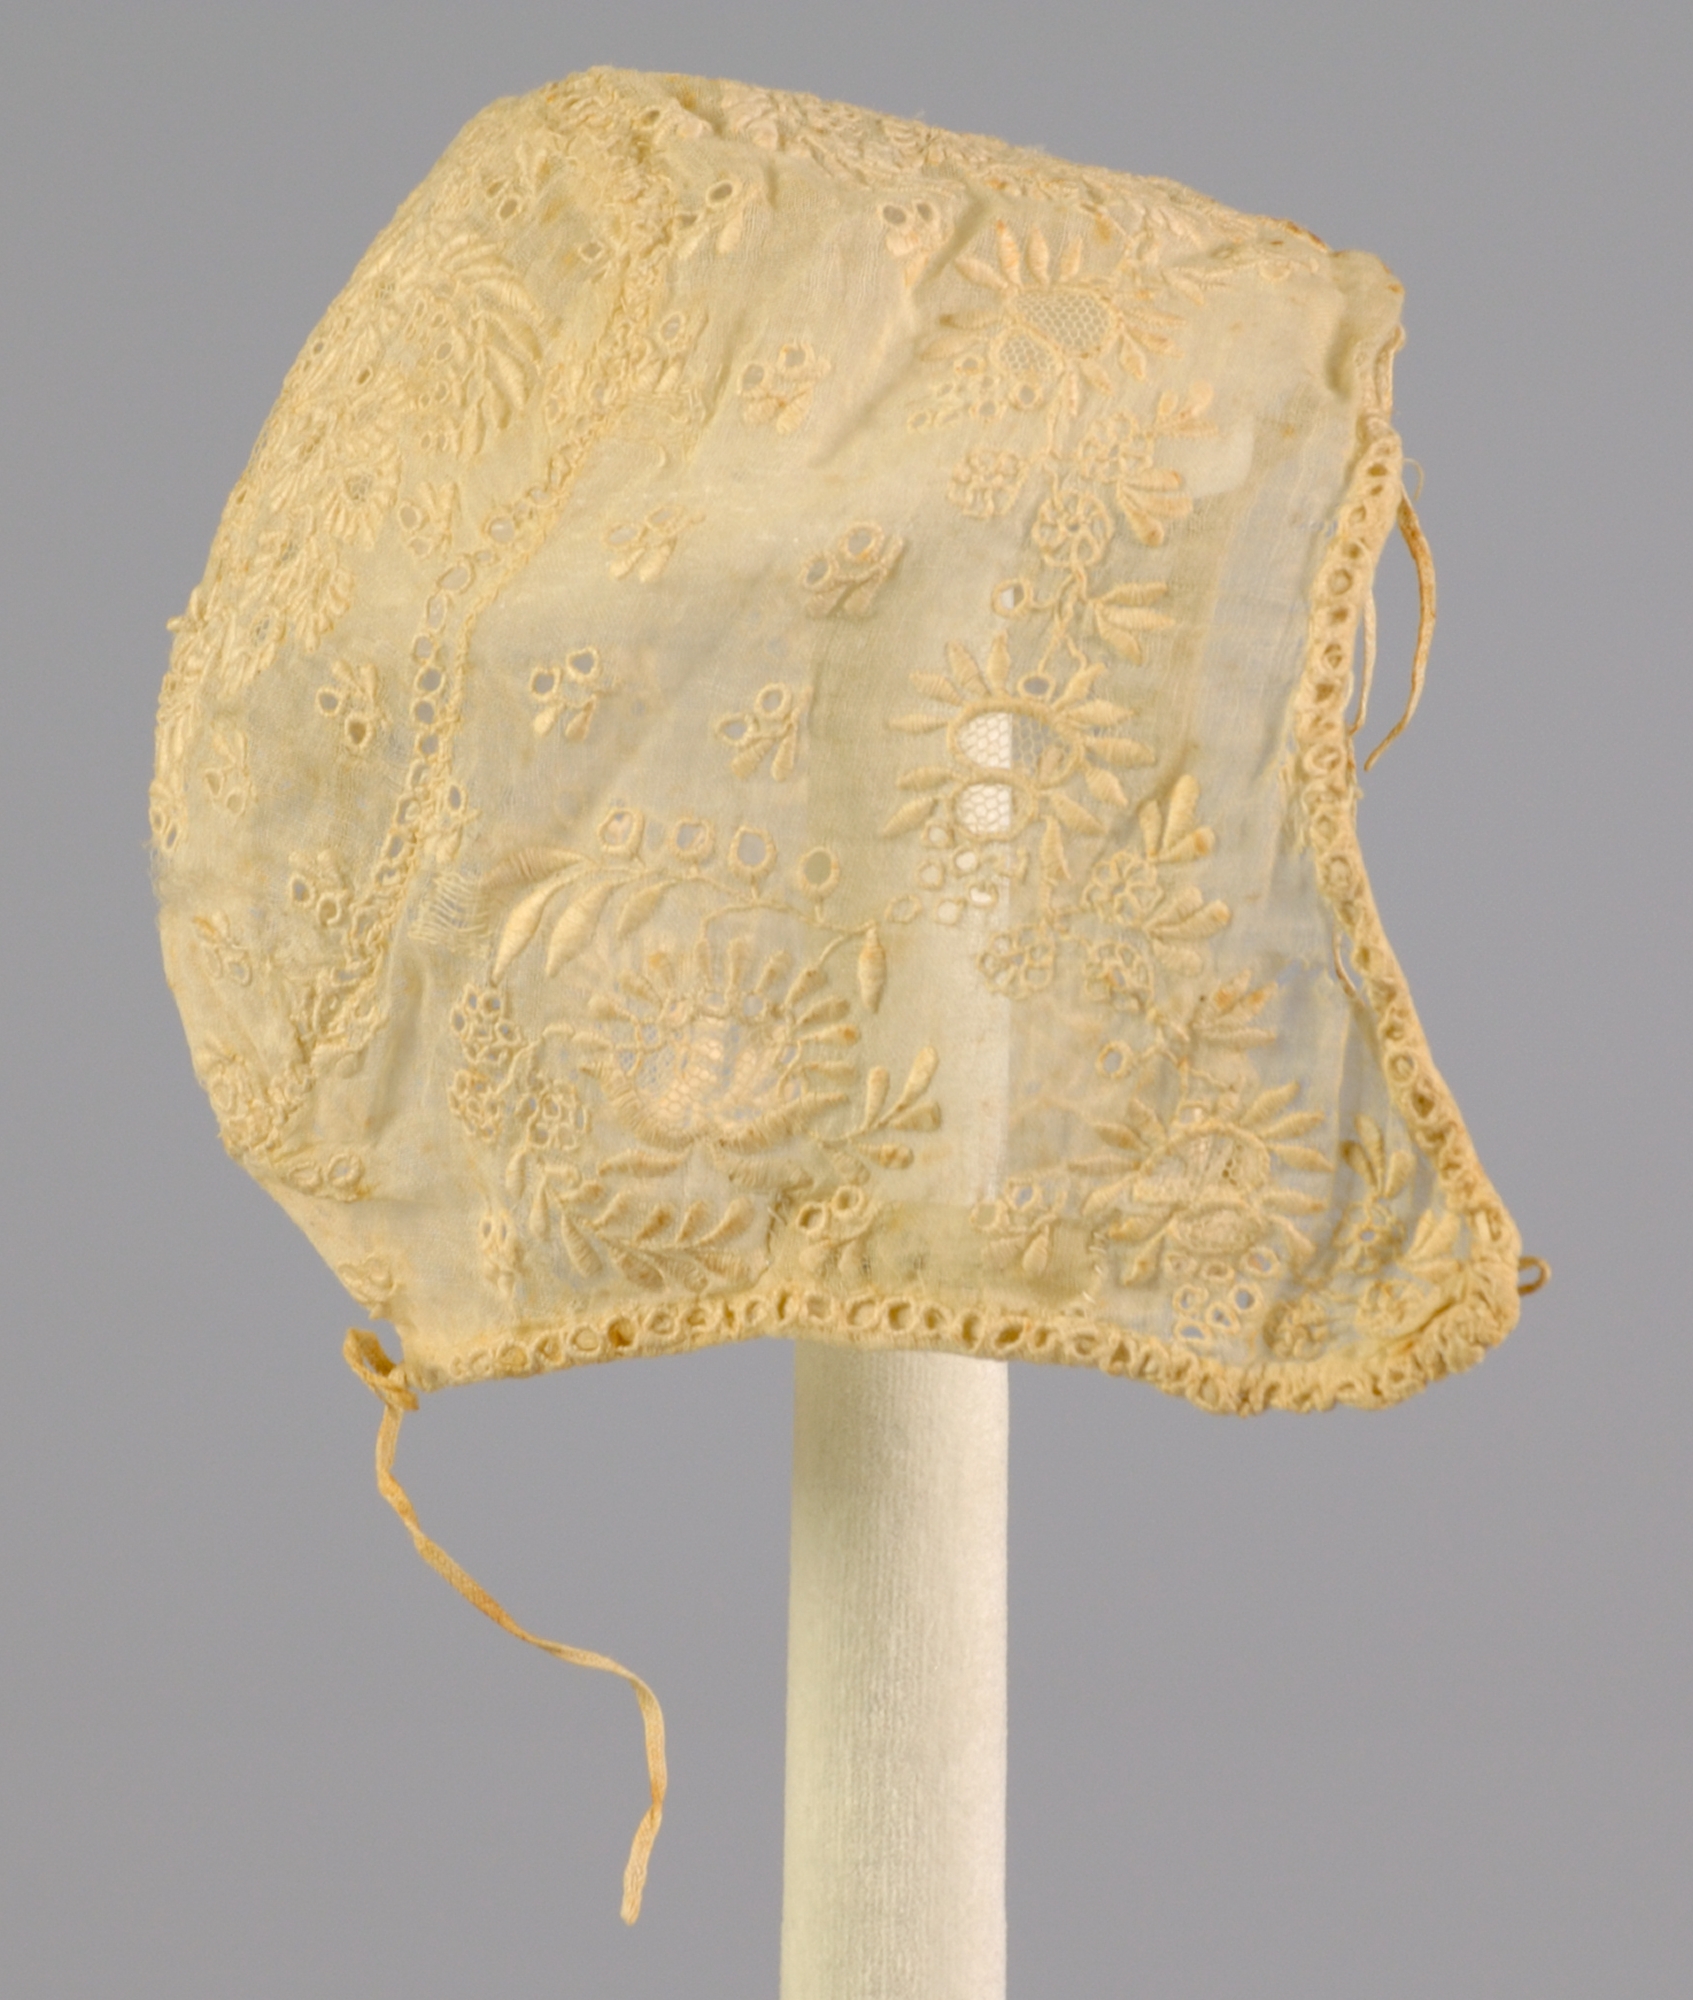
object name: cap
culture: american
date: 1835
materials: cotton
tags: flowers